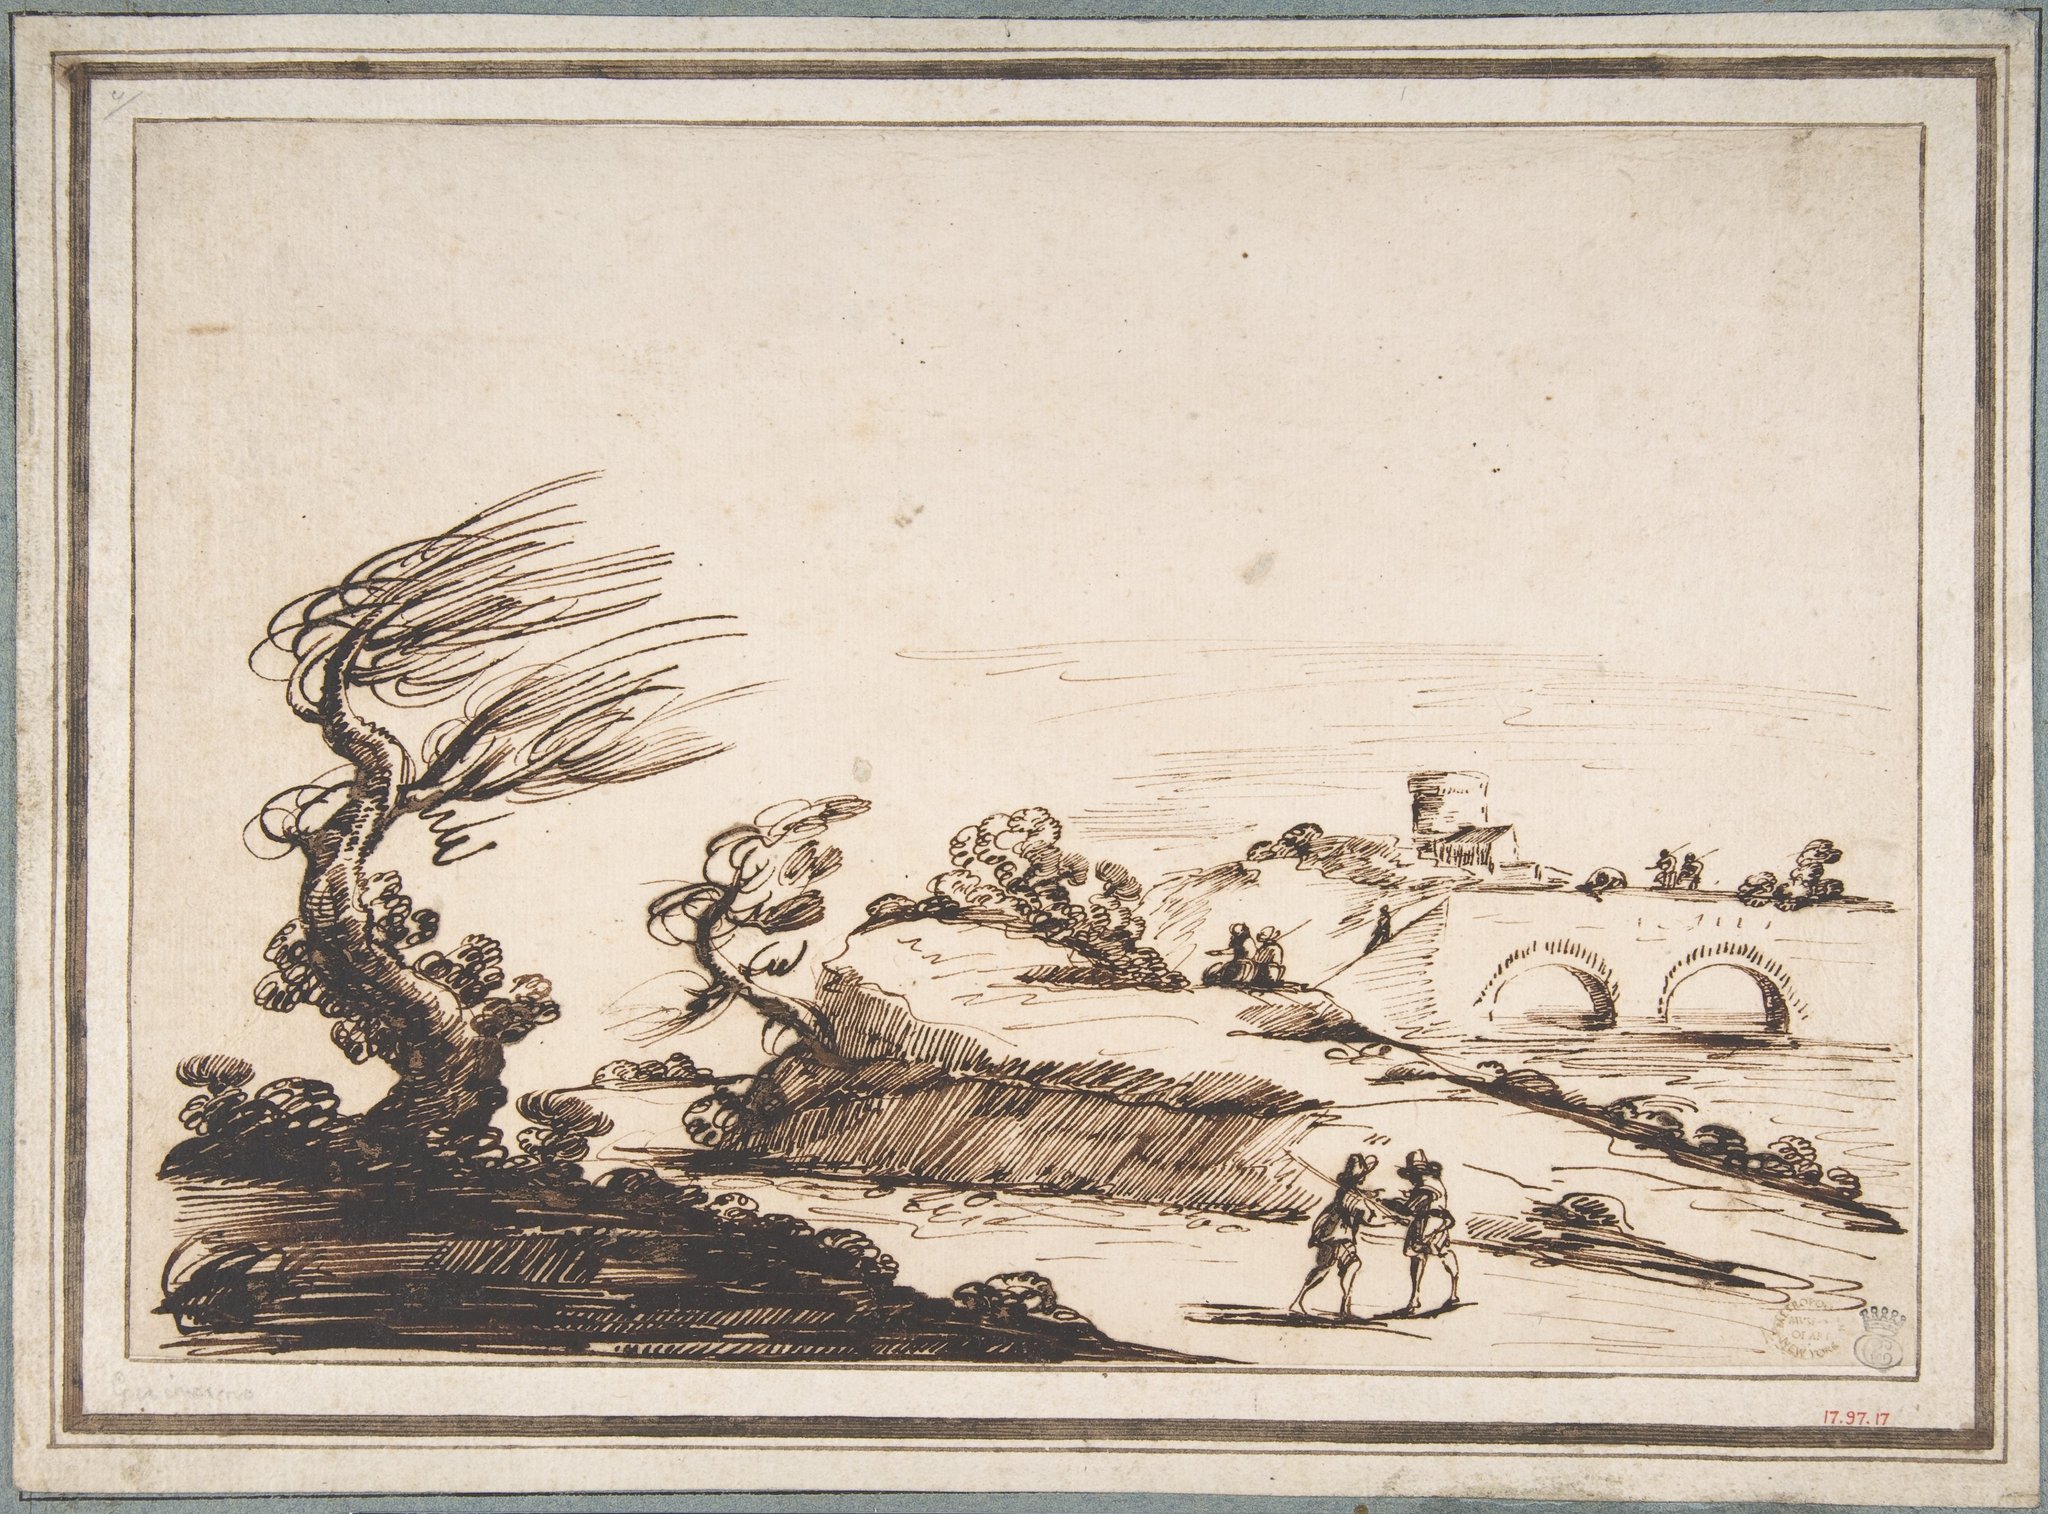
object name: drawing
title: Landscape with Figures and a Two-Arched Bridge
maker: guercino (giovanni francesco barbieri)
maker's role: artist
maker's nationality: italian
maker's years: 1591-1666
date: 1591-1666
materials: ink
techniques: brush, pen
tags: bridges,landscapes